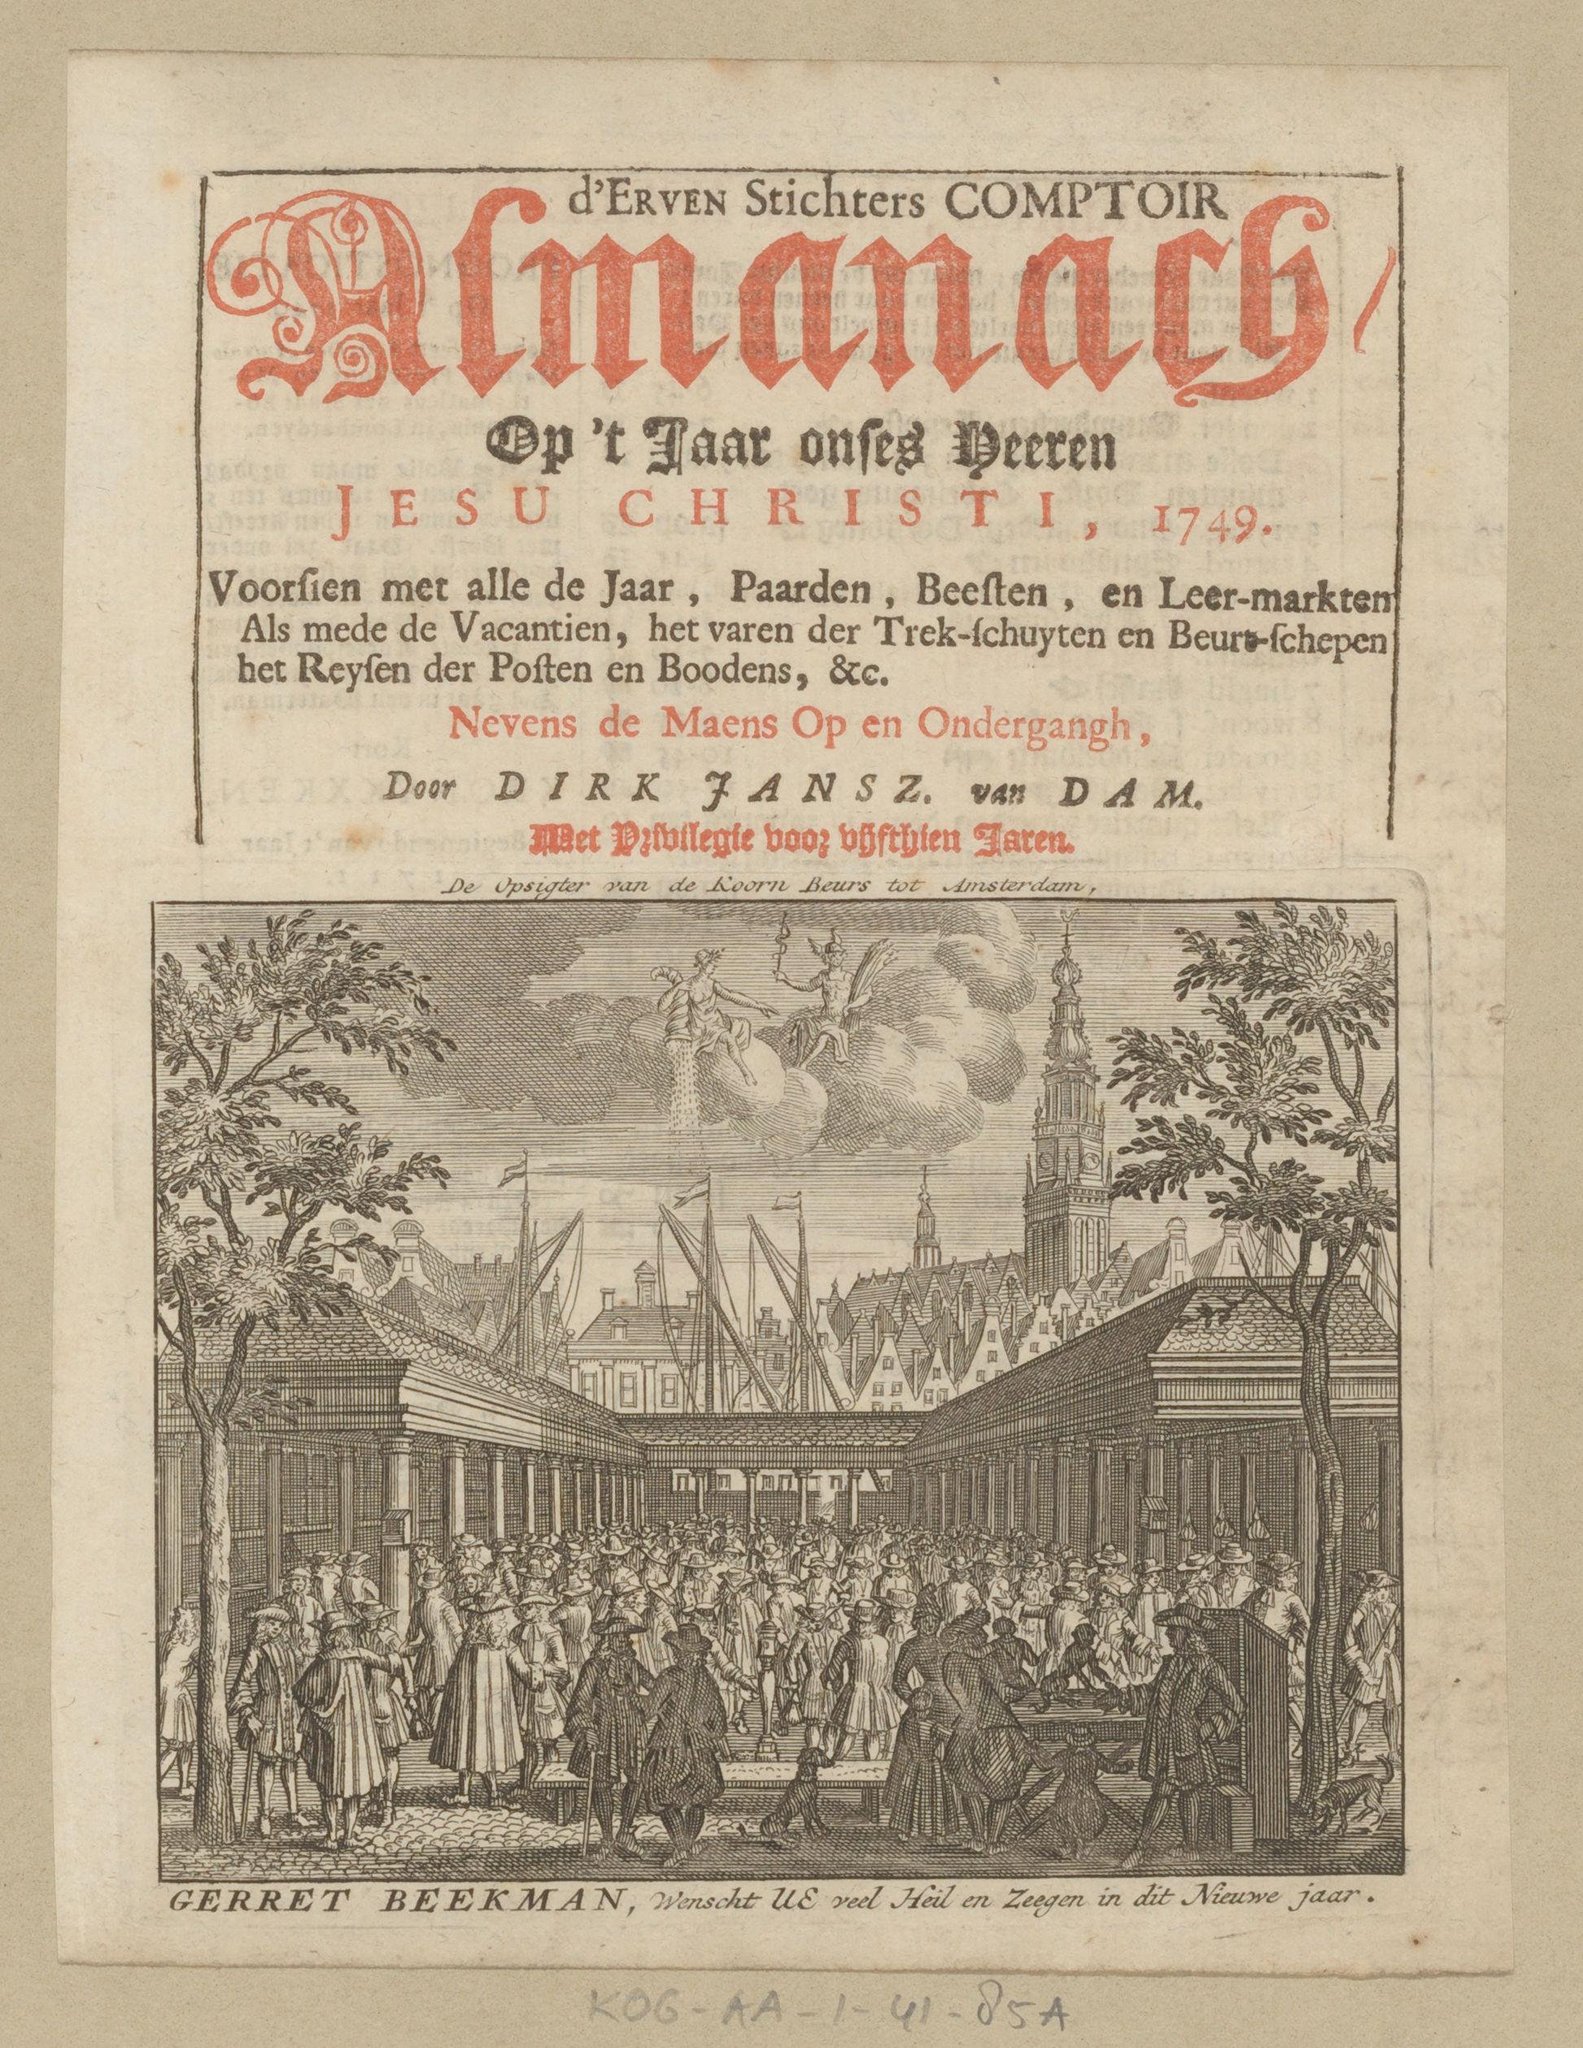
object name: print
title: Titelpagina voor: Dirk Jansz van Dam, Almanack op 't Jaar onses Heeren Jesu Christi, 1749 (...)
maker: Anonymous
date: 1749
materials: paper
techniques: engraving, etching, letterpress printing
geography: amsterdam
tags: calendar, almanac, sailing-ship, sailing-boat, market-hall, parts of church exterior and annexes: tower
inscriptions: collector's mark: ‘41-85’ Lugt 1641b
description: Titelpagina voor: Dam, Dirk Jansz van. d'Erven Stichters Comptoir Almanack, Op 't Jaar onses Heeren Jesu Christi, 1749. (...). Amsterdam: Erfgenamen van de Wed. C. Stichter, 1749.